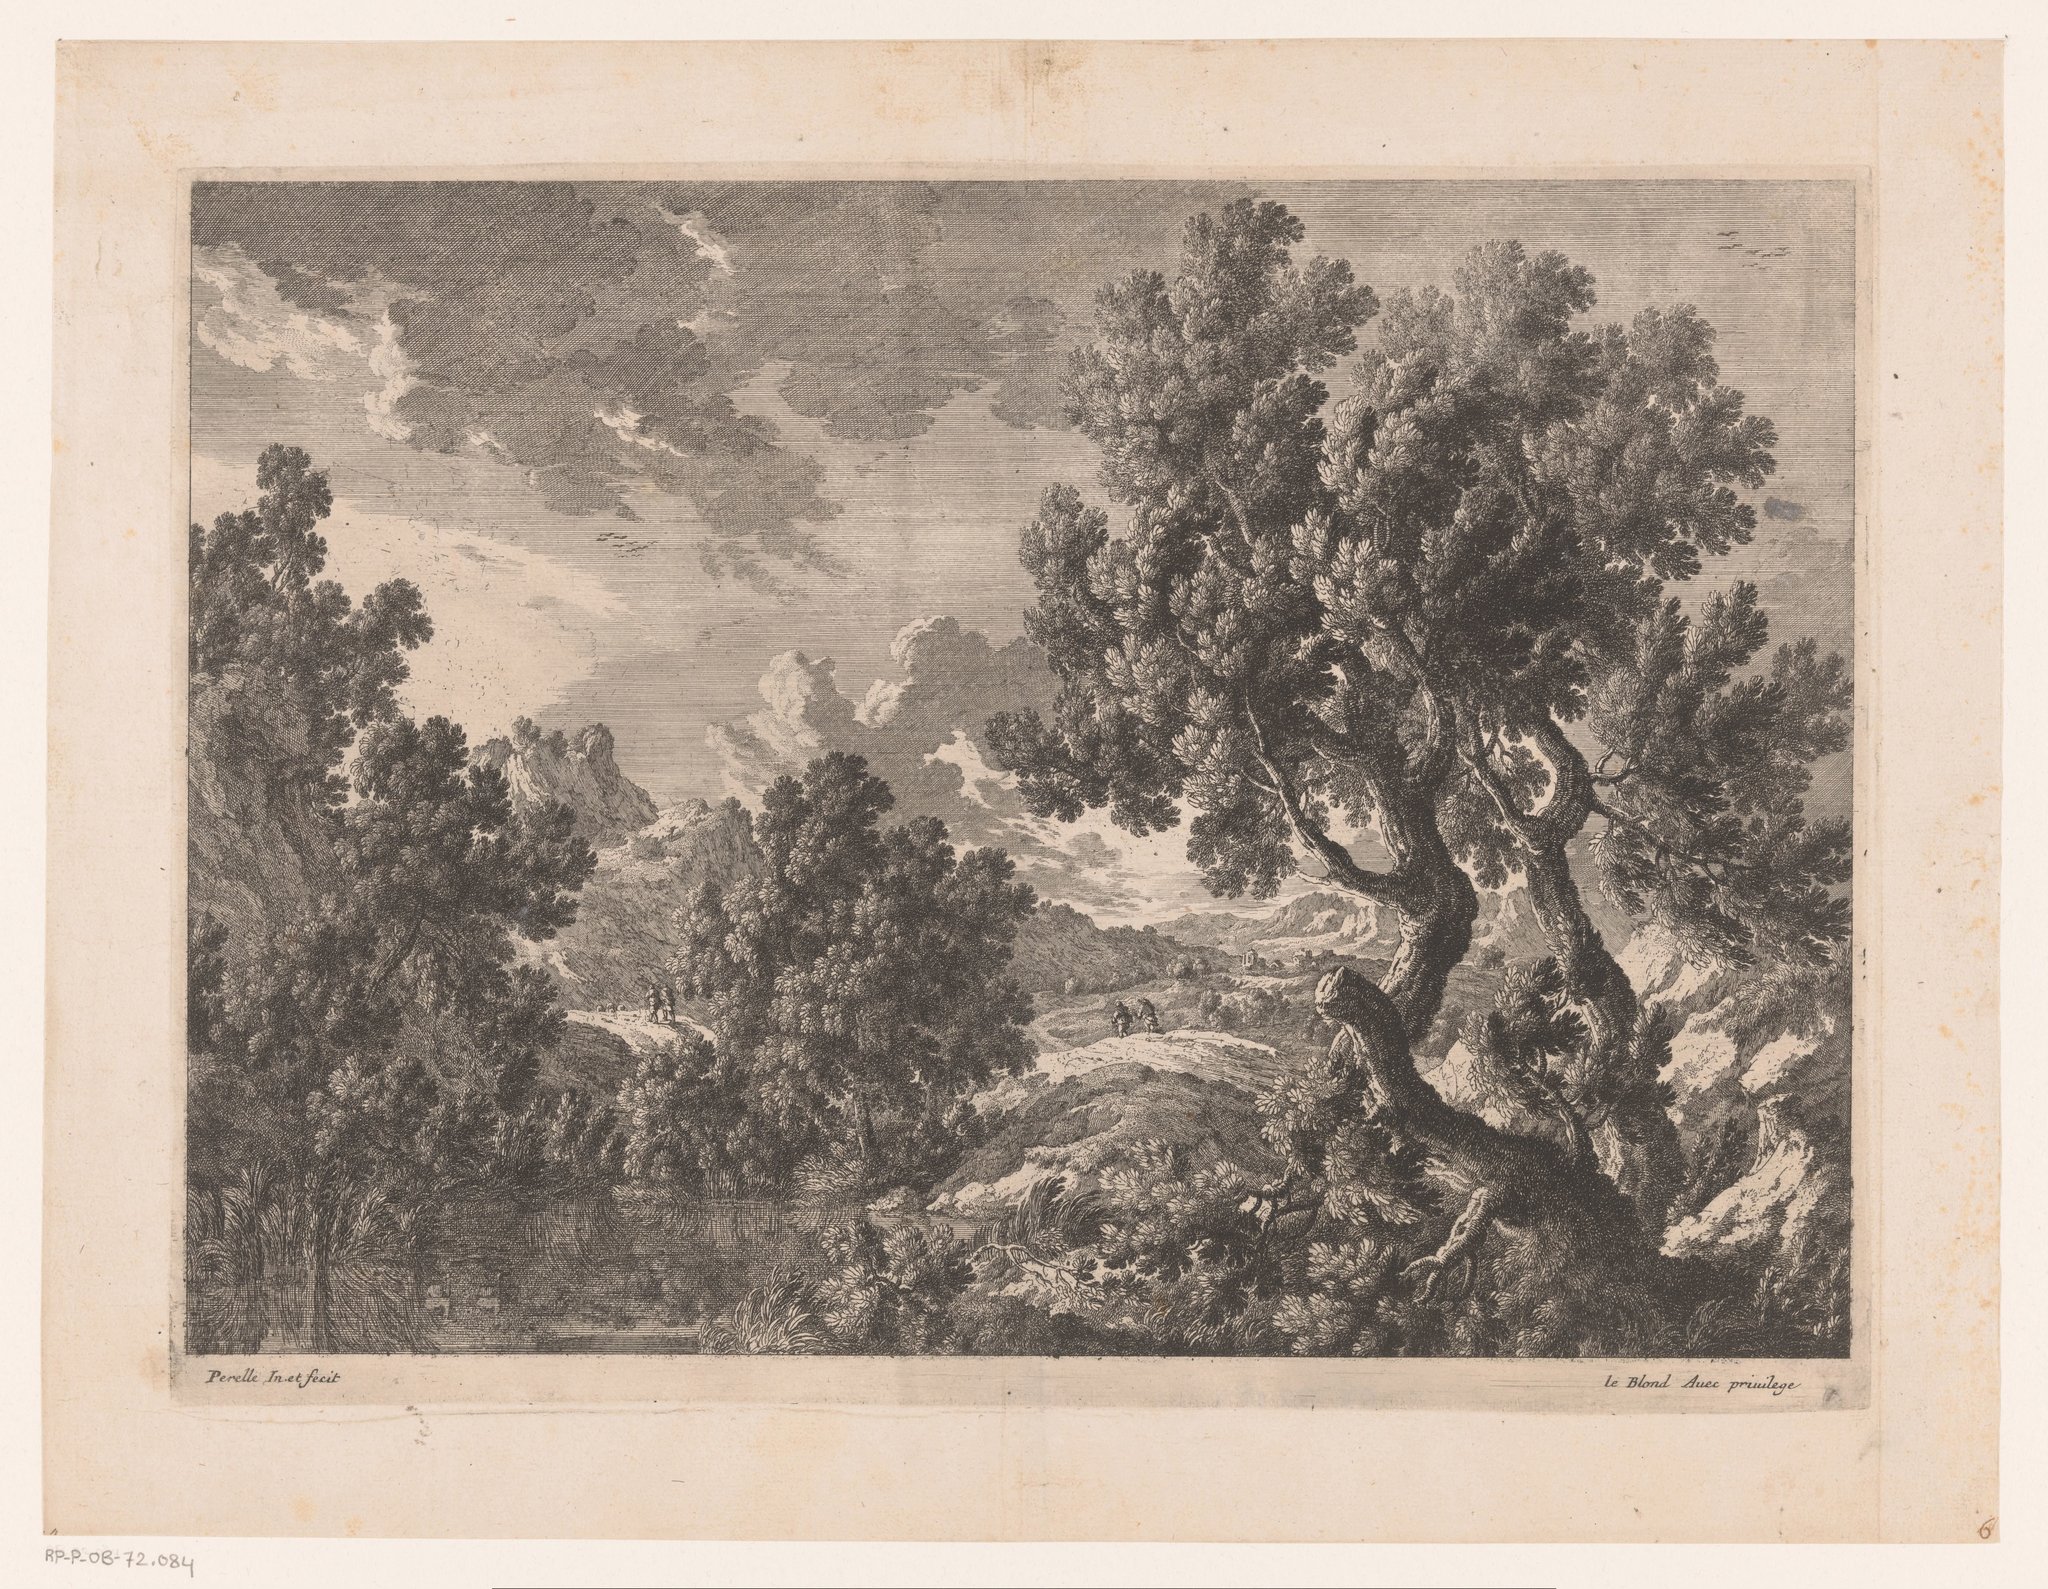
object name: print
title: Rotsachtig landschap met bomen aan water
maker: jean leblond (i)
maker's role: publisher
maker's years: 1590-1666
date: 1613-1666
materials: paper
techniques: engraving, etching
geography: france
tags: landscapes with waters, waterscapes, seascapes (in the temperate zone), mountains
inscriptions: collector's mark: Lugt 240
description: Prenten met het signatuur 'Perelle' kunnen zowel door vader Gabriel als door zonen Nicolas en Adam gemaakt zijn.